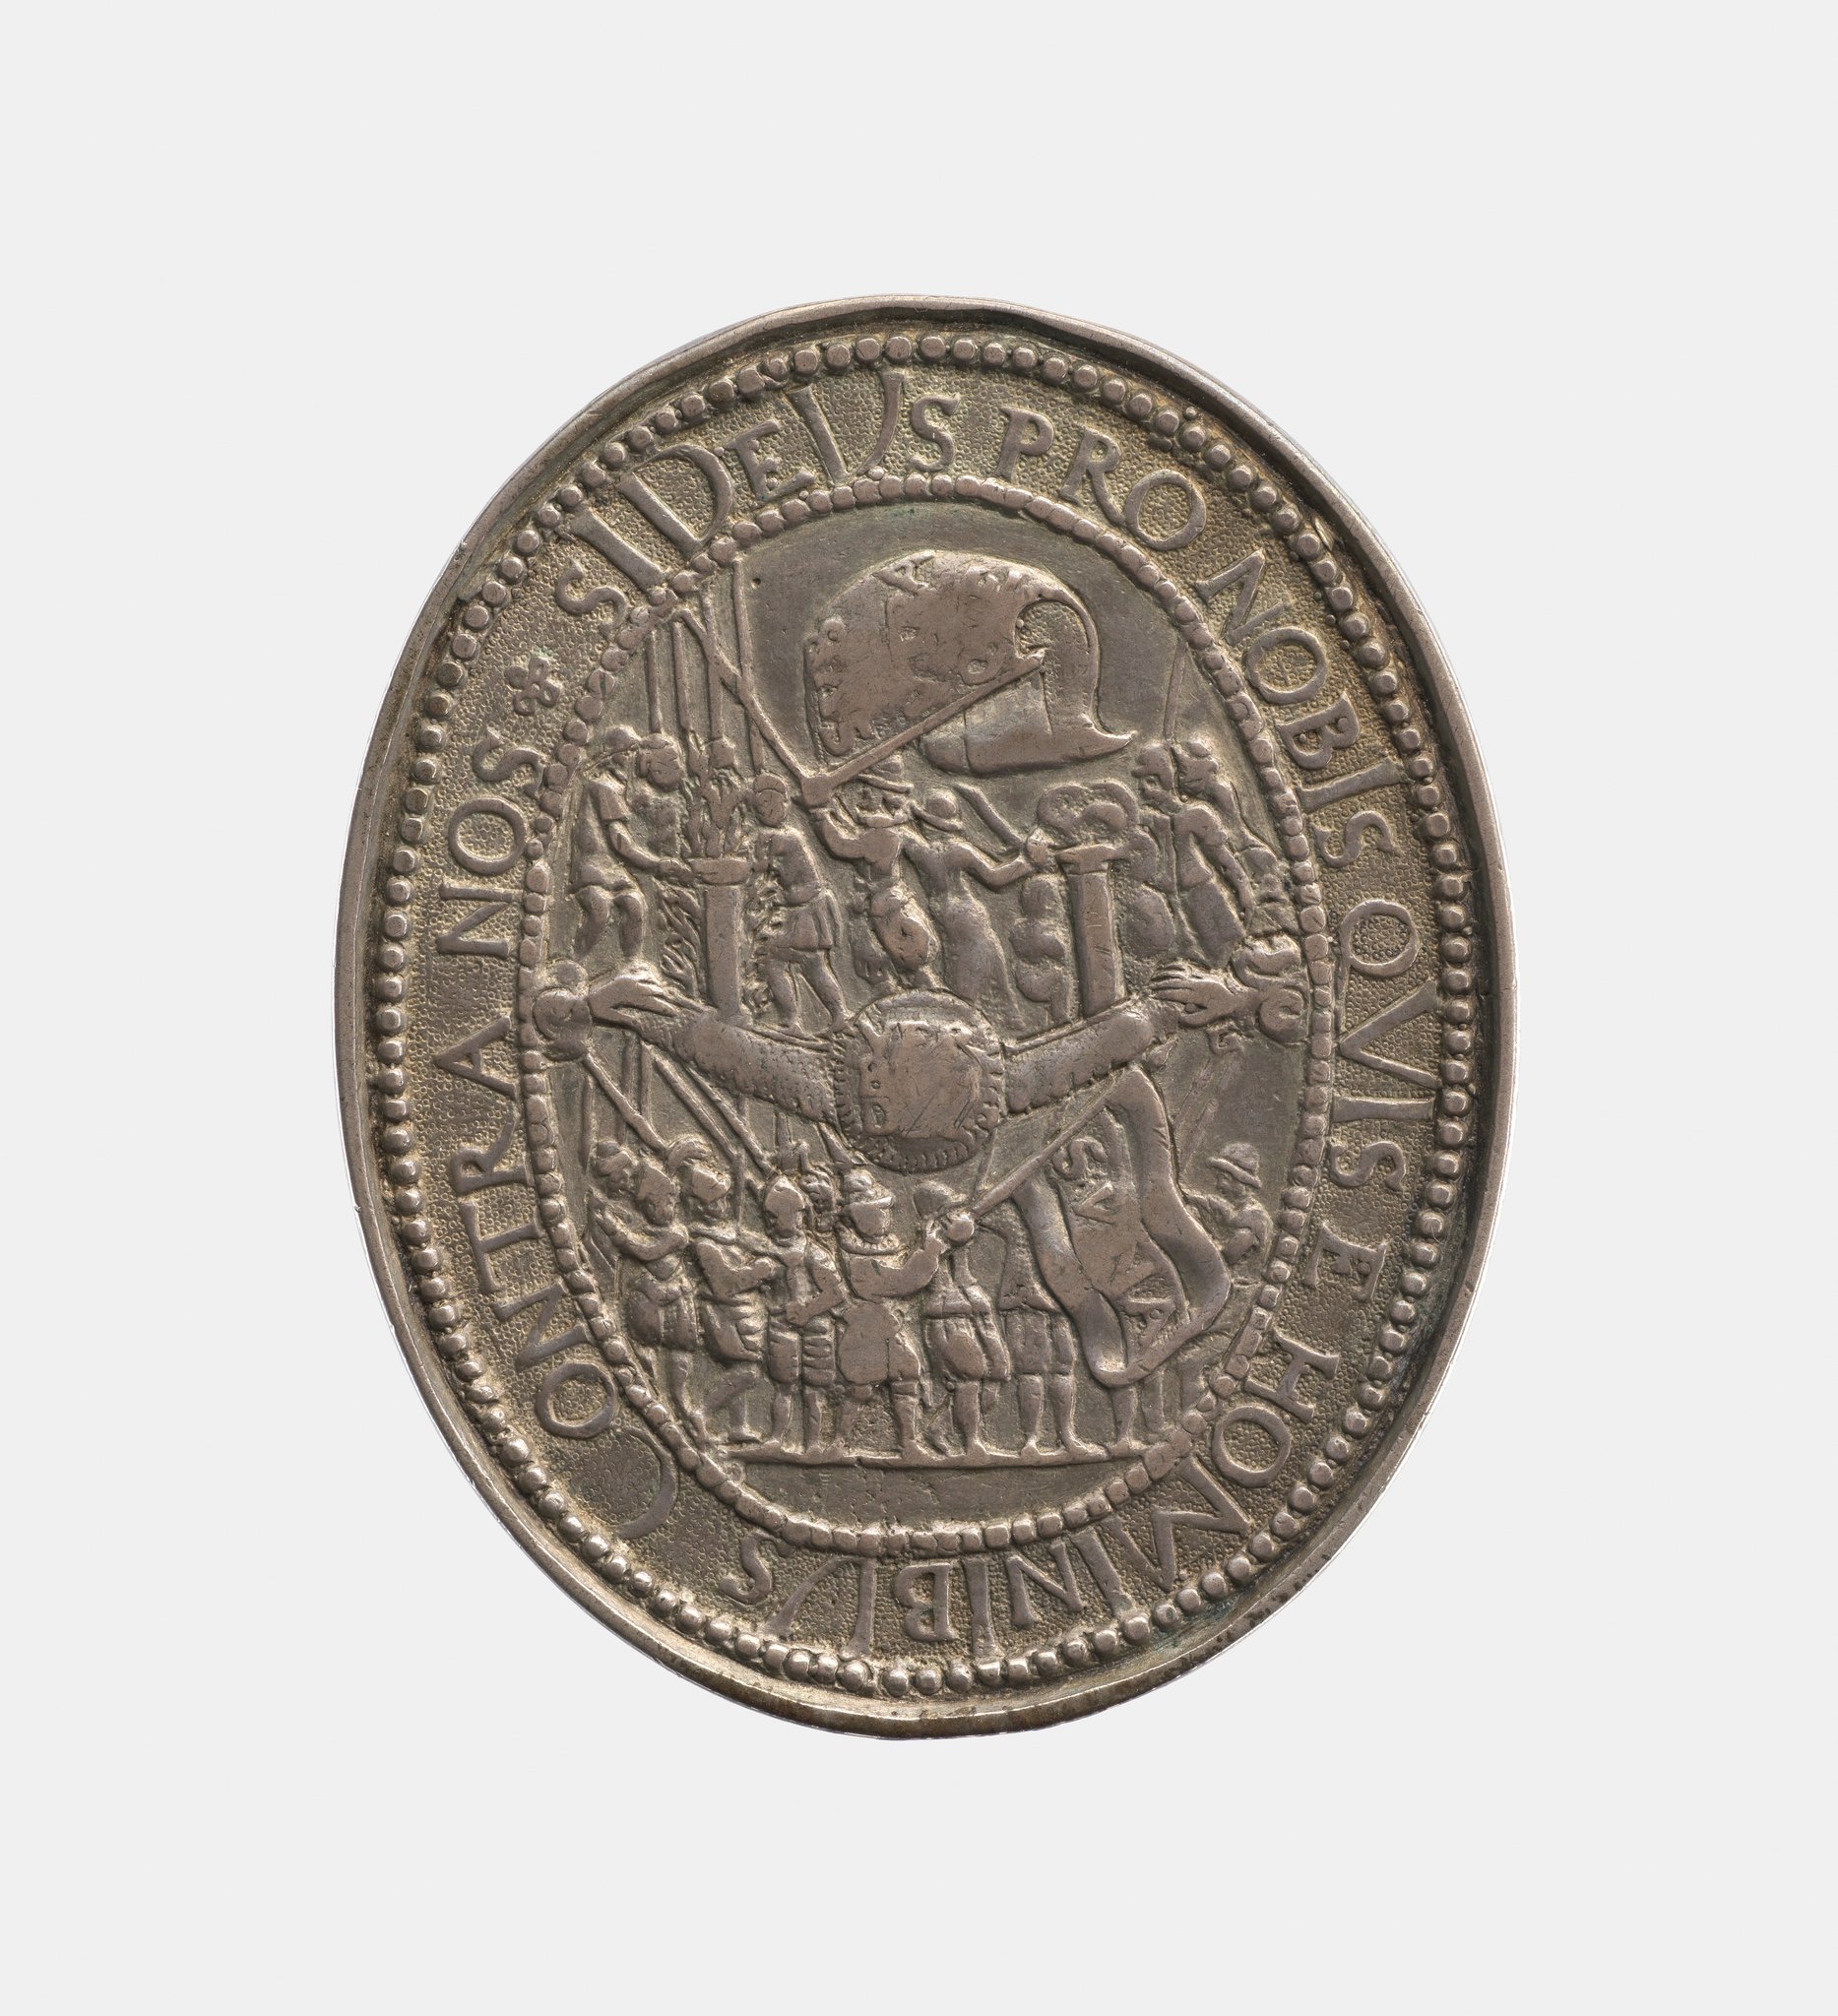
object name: medal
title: Protestant League in Bohemia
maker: Anonymous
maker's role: artist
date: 1619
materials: silver